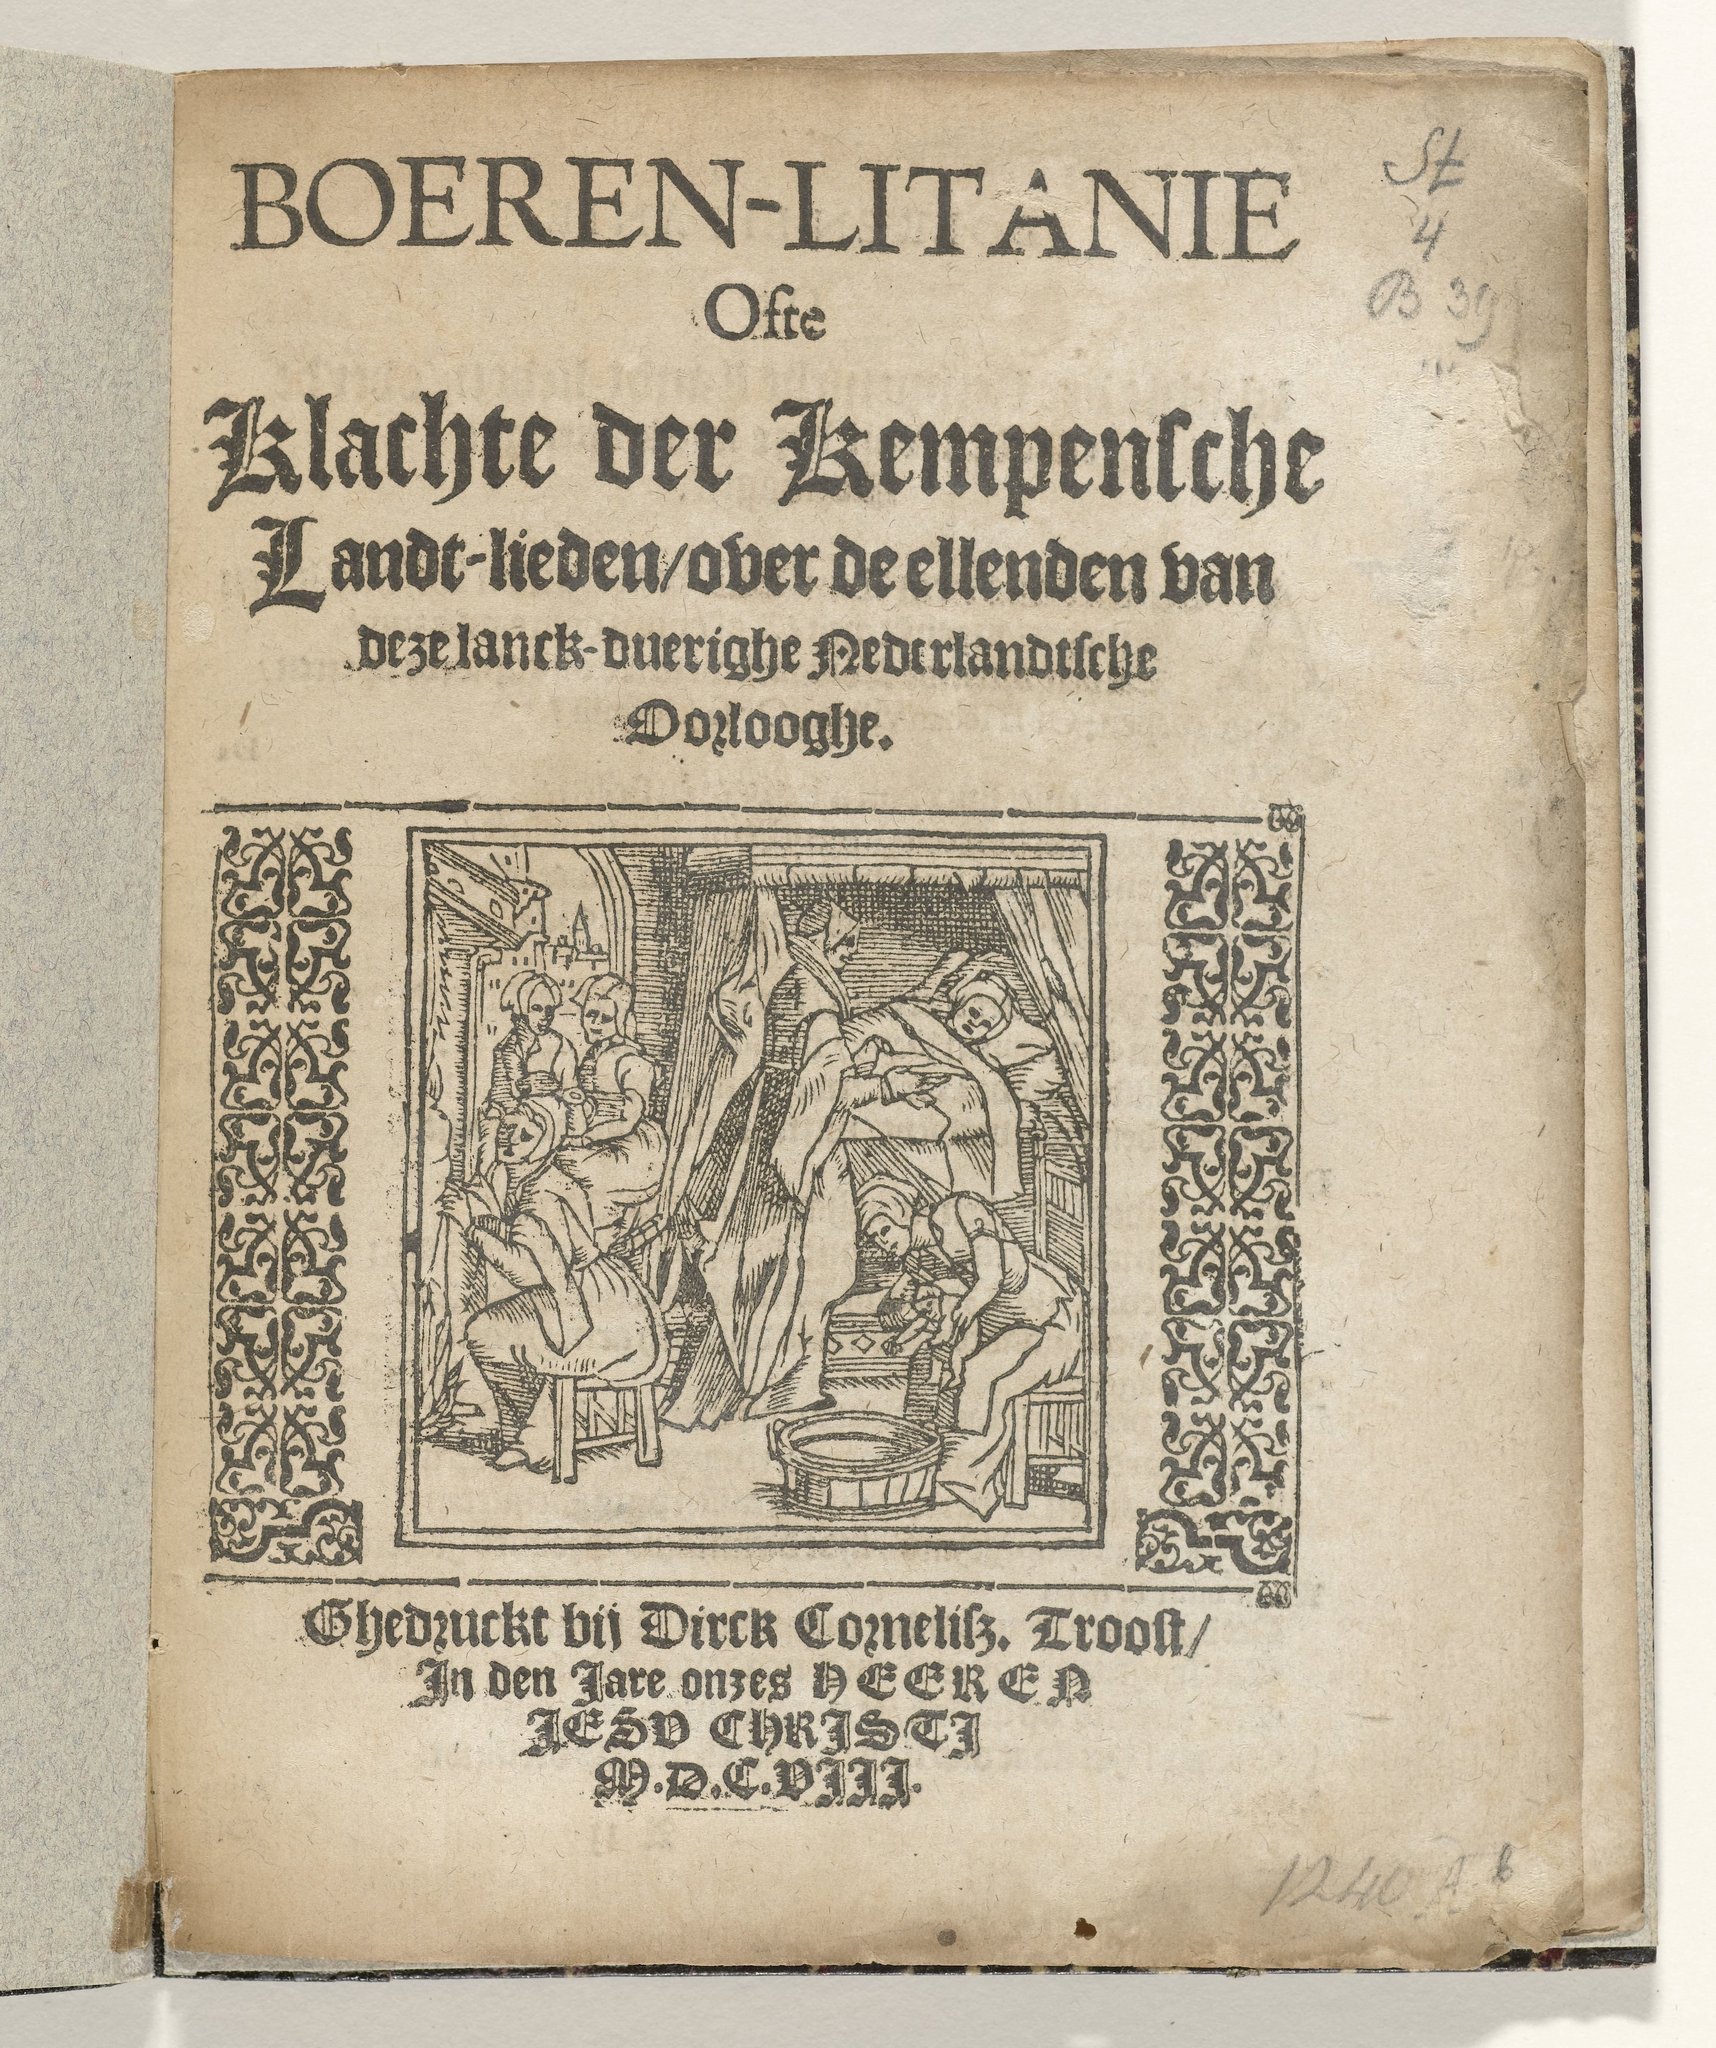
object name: titelblad, titelpagina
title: Titelpagina van het pamflet: Boeren-Litanie ofte Clachte der Kempensche Landt-lieden over de ellenden van deze lanck duerighe Nederlantsche Ooologhe, 1608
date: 1608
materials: paper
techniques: letterpress printing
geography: northern netherlands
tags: woman giving birth (lying-in)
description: Het eerste exemplaar van dit pamflet heeft een heel andere titelprent: Boeren-Litanie ofte Clachte der Kempensche Landt-lieden over de ellenden van deze lanck duerighe Nederlantsche Oorlooghe, nummer FMH 1240Aa in de pamflettencollectie.